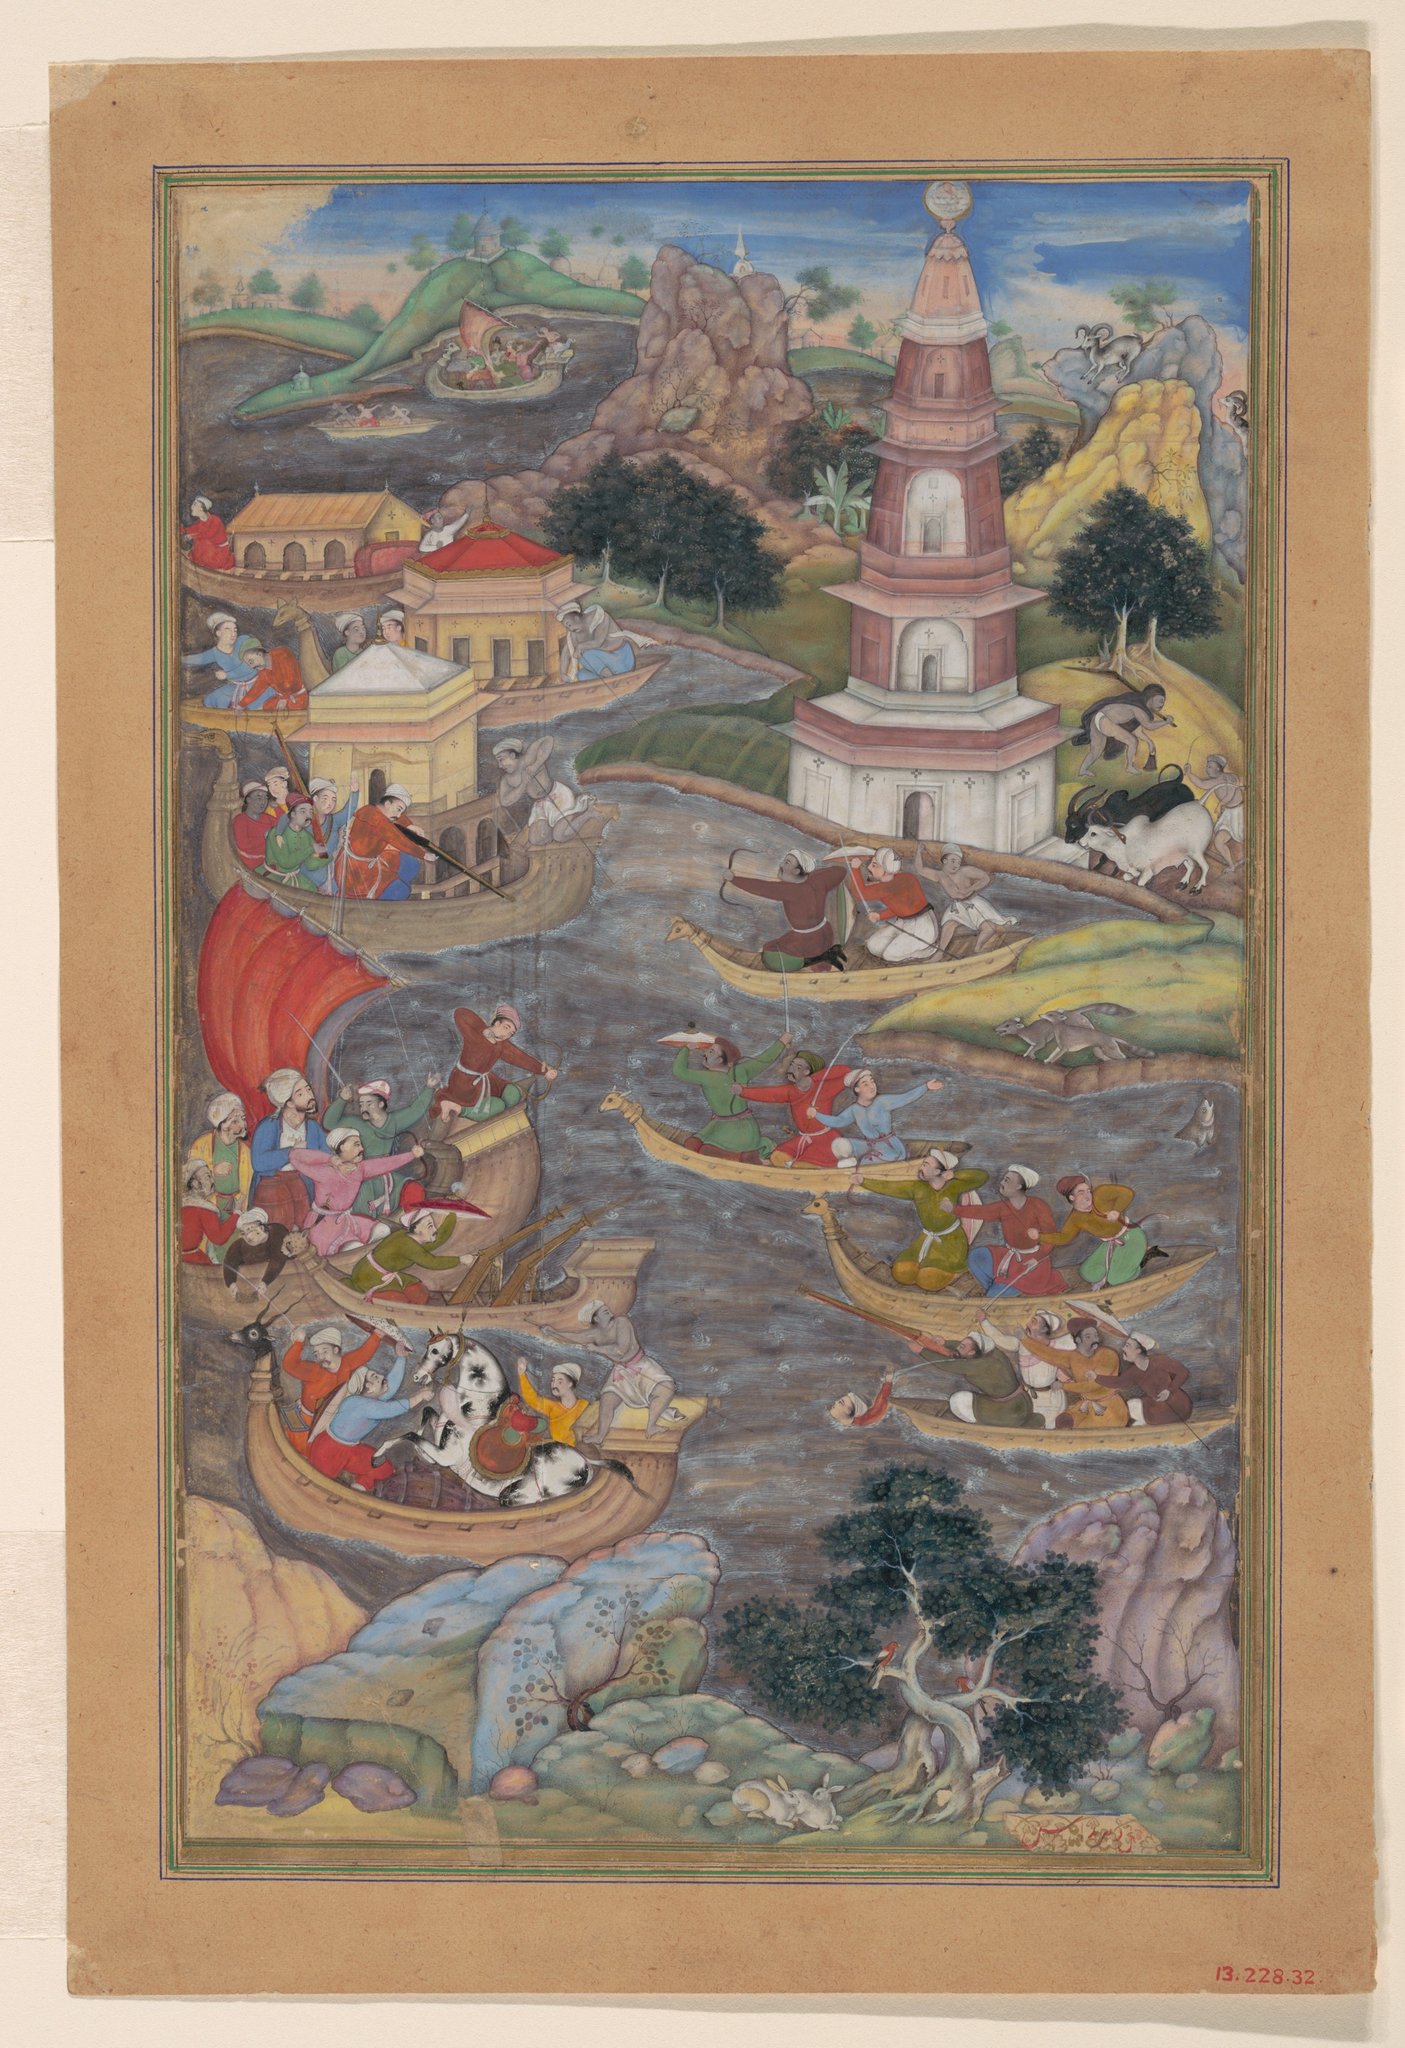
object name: folio from an illustrated manuscript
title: "Alexander Fights a Sea Battle", Folio from a Khamsa (Quintet) of Amir Khusrau Dihlavi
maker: amir khusrau dihlavi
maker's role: author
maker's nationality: indian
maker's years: 1228-1350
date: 1597-1598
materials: gold, ink, paper, watercolor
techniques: dyeing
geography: india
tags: towers,battles,alexander the great,men,horses,rabbits,boats,ox